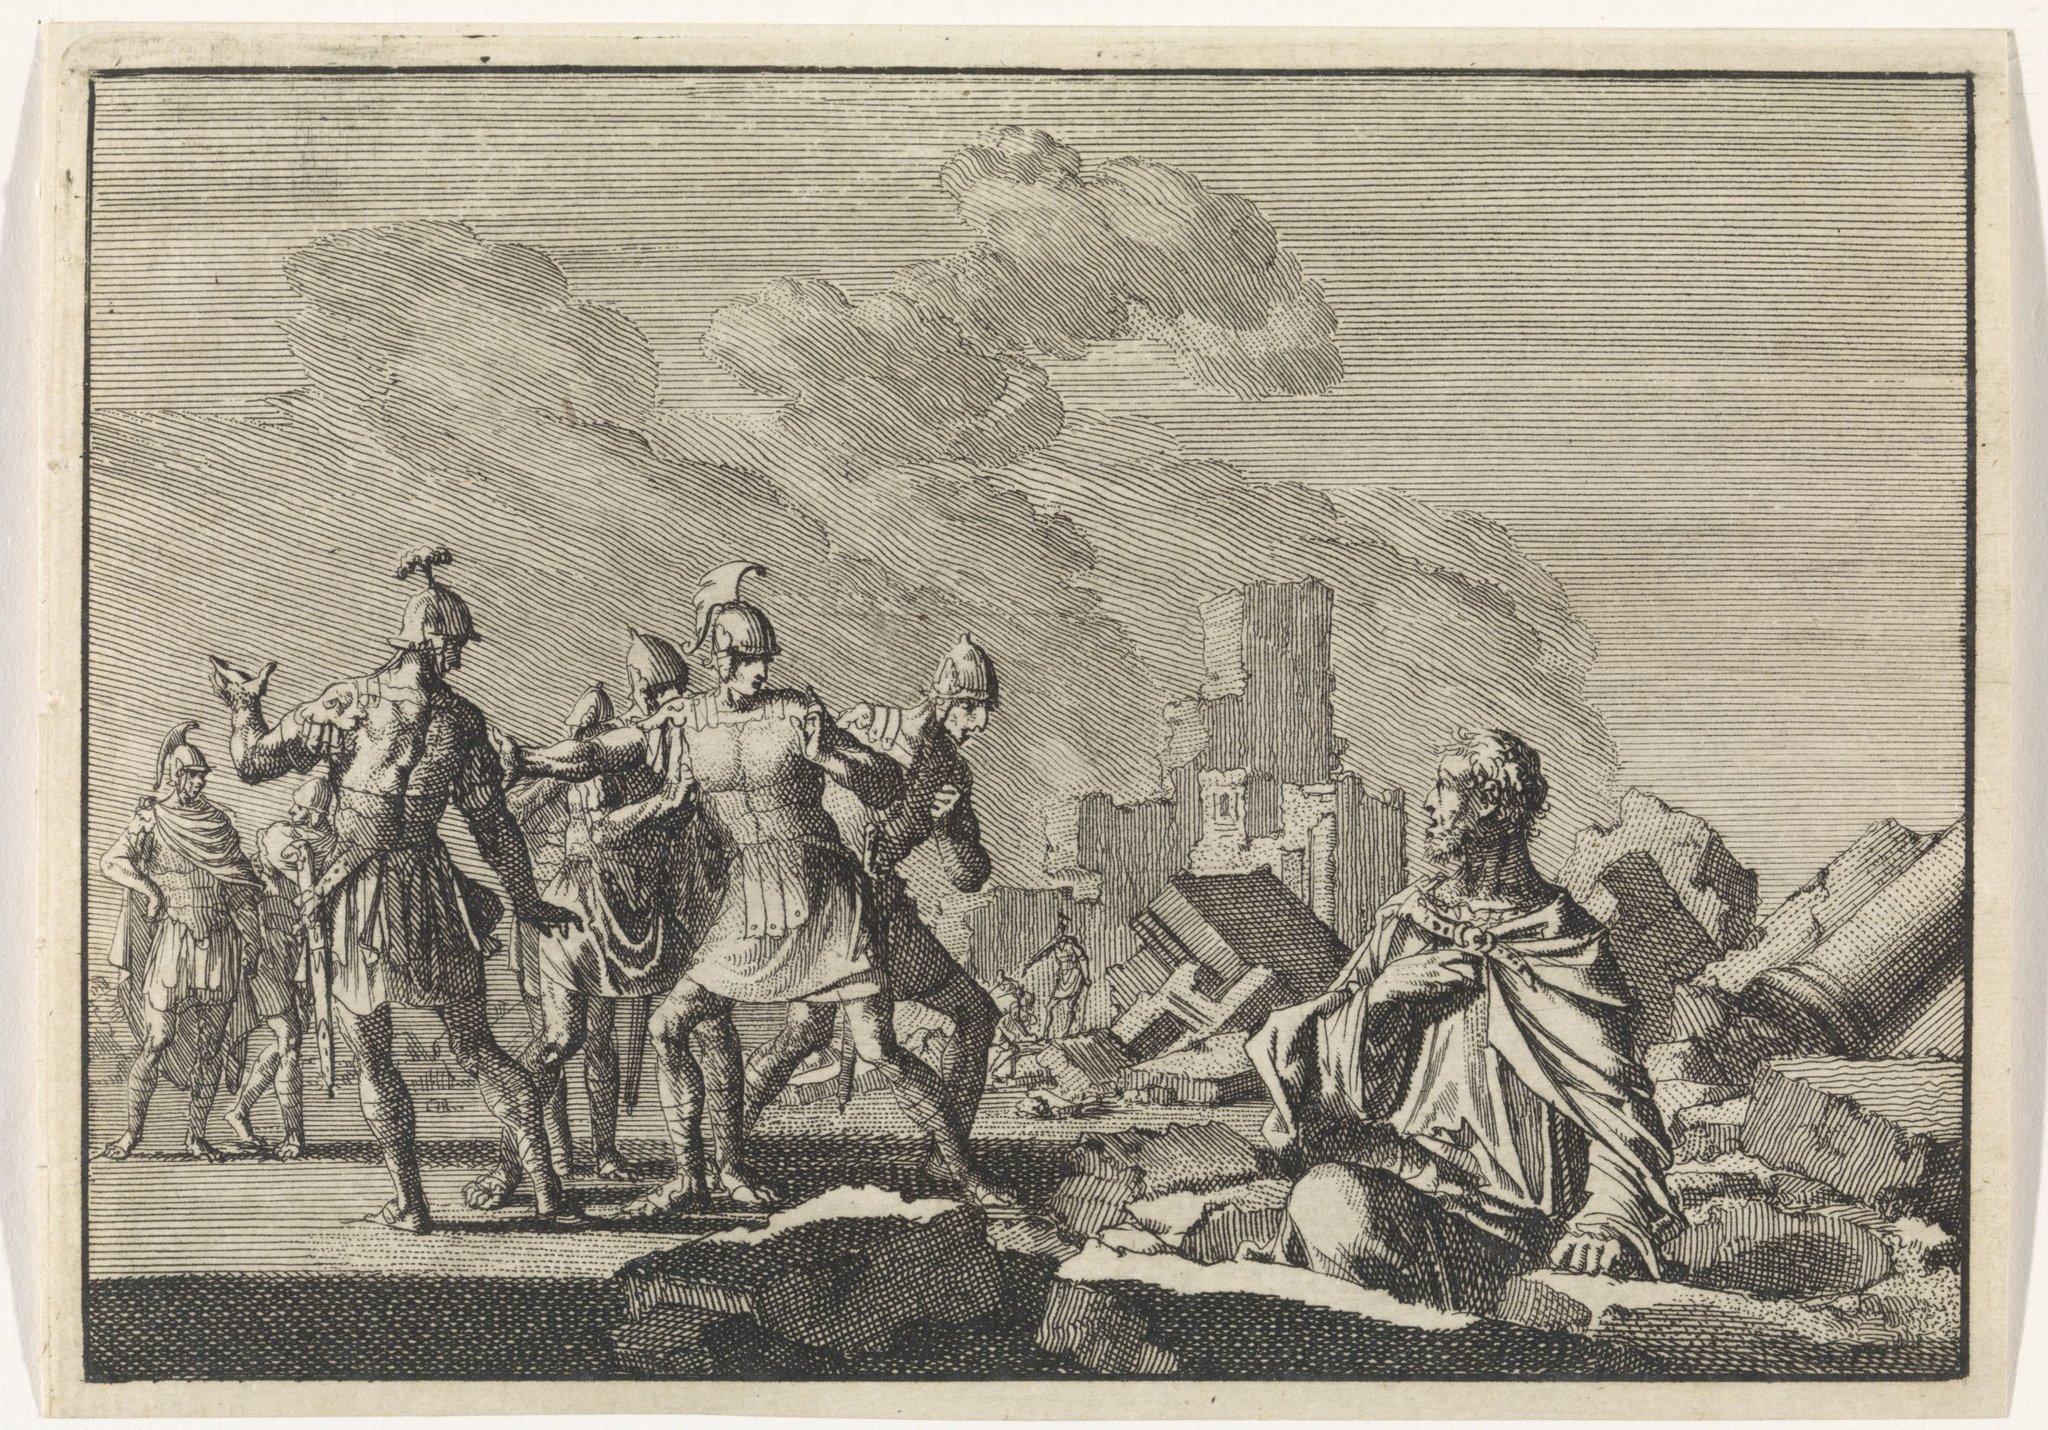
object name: print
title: Simon, Giora´s zoon, komt tevoorschijn uit de puinhopen van de tempel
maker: jan luyken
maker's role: draughtsman, print maker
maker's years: 1649-1712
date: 1704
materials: paper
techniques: etching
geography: amsterdam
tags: ruin of church, monastery, etc.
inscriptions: collector's mark: Lugt 2228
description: Prent ook gebruikt als boekillustratie in: Josephus, Flavius. Alle de Werken, 2 delen. Amsterdam: Pieter Mortier, 1704, dl. 2, p. 699.